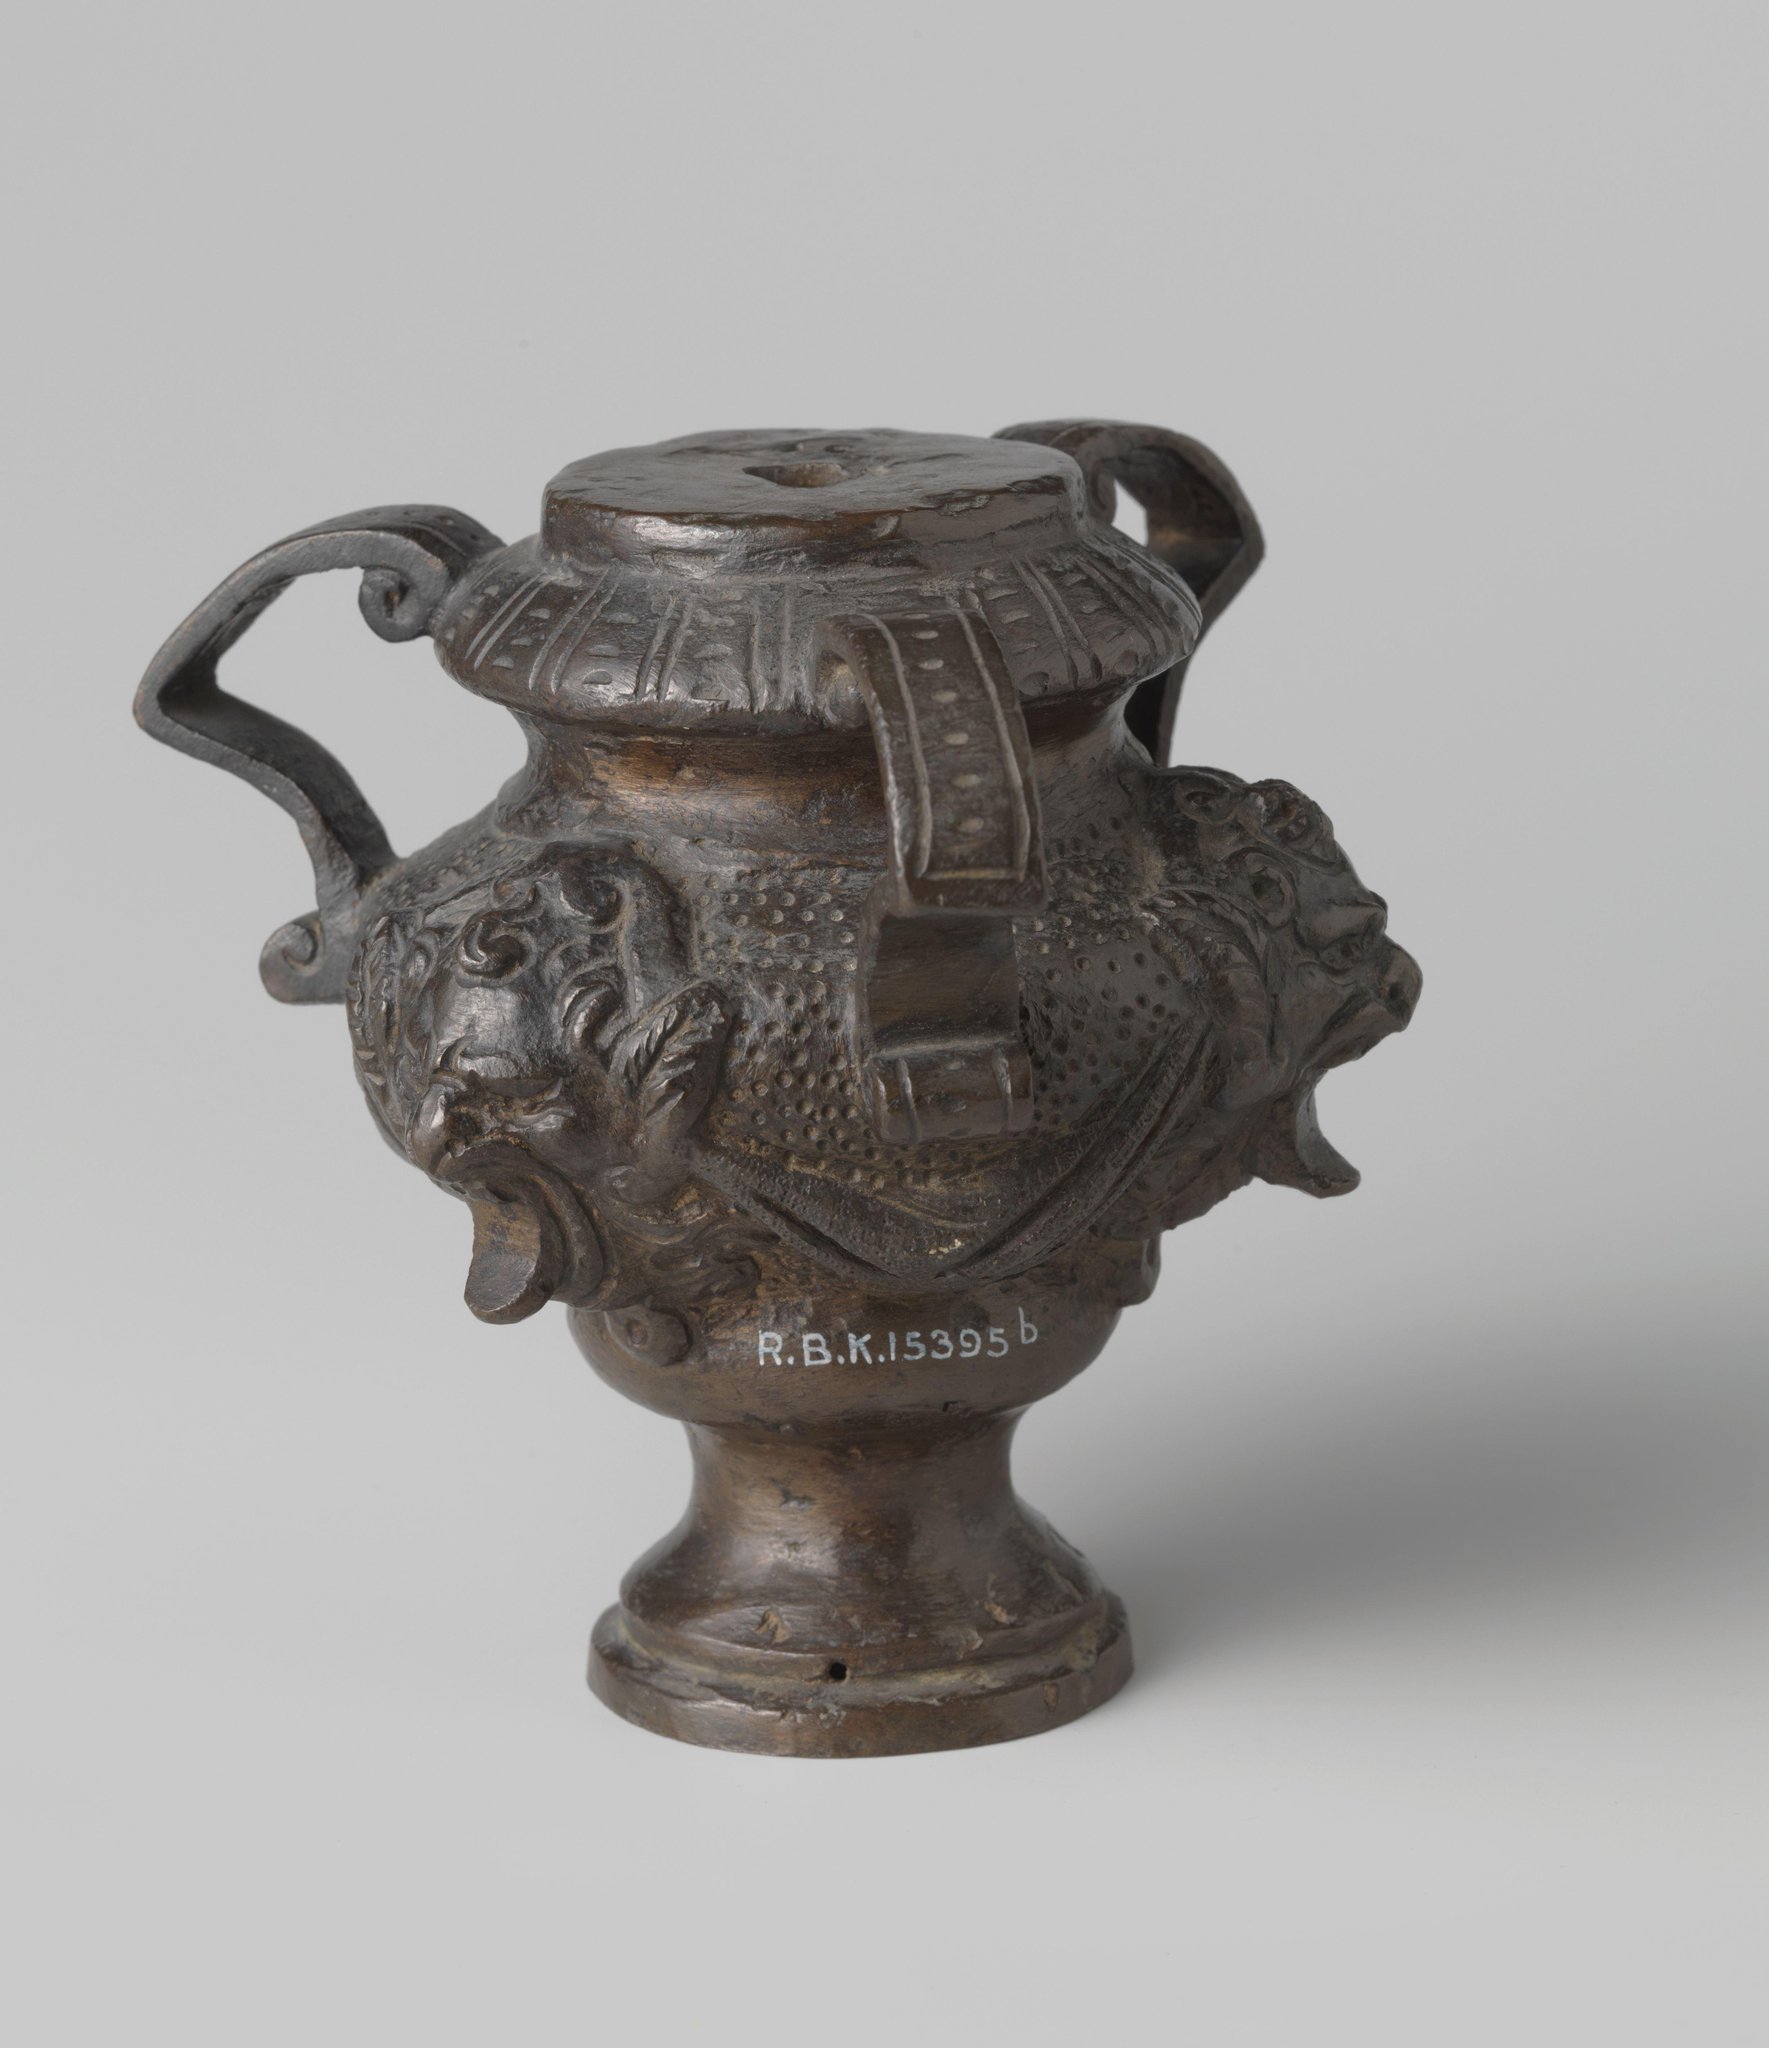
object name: sculpture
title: Vaasvormig onderdeel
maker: jacopo della quercia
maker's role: sculptor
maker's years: 1367-1438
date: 1575-1599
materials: bronze, plaster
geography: venice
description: Op de buik, die gezand is, drie leeuwekoppen, onderling verbonden door drie 'doekguirlandes'. Hierboven drie oren, gevormd uit geknakte, bandvormige S-voluten.